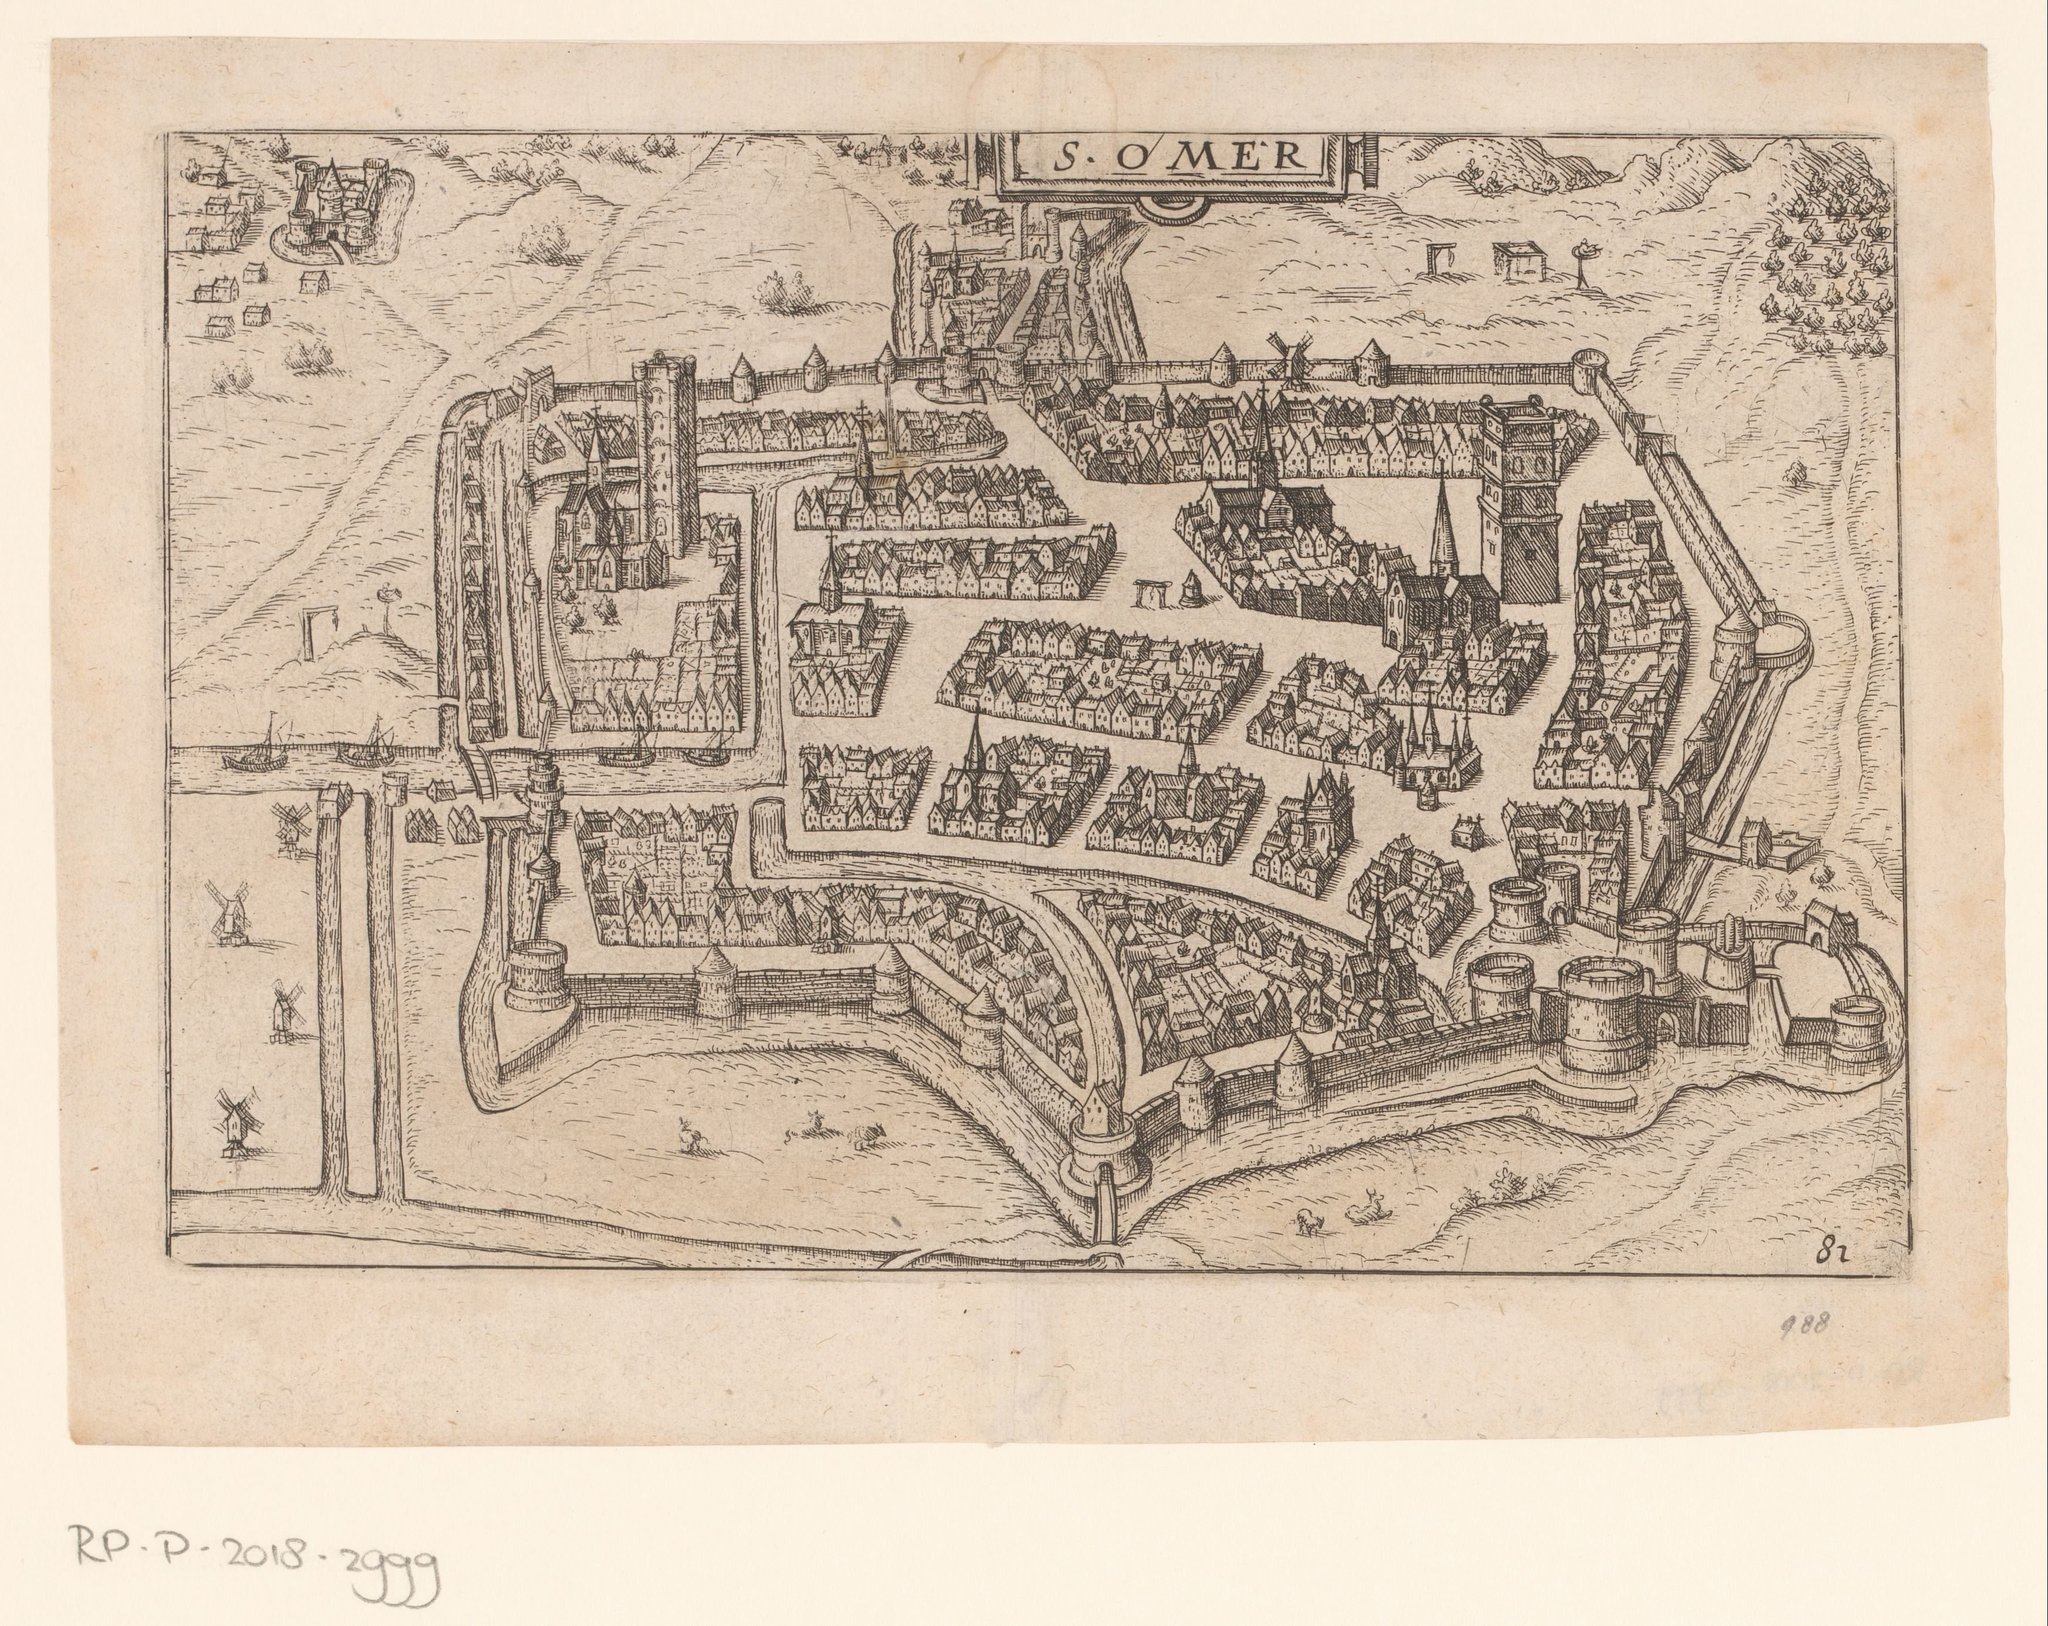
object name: area plan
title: S. Omer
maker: Anonymous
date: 1612-1648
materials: paper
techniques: etching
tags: fortified city, maps of cities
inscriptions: collector's mark: Lugt 2228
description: Deze staat van prent voor het eerst gebruikt in: Guicciardini, Lodovico. Beschryvinghe van alle de Neder-landen, anderssins ghenoemt Neder-Duytslandt (…). Amsterdam: Willem Janszoon Blaeu, 1612. Hierna is deze prent tot 1648 nog gebruikt in latere uitgaven van deze publicatie, uitgegeven door Blaeu en daarna door Janssonius. Uit welke uitgave het huidige exemplaar precies komt is niet na te gaan.